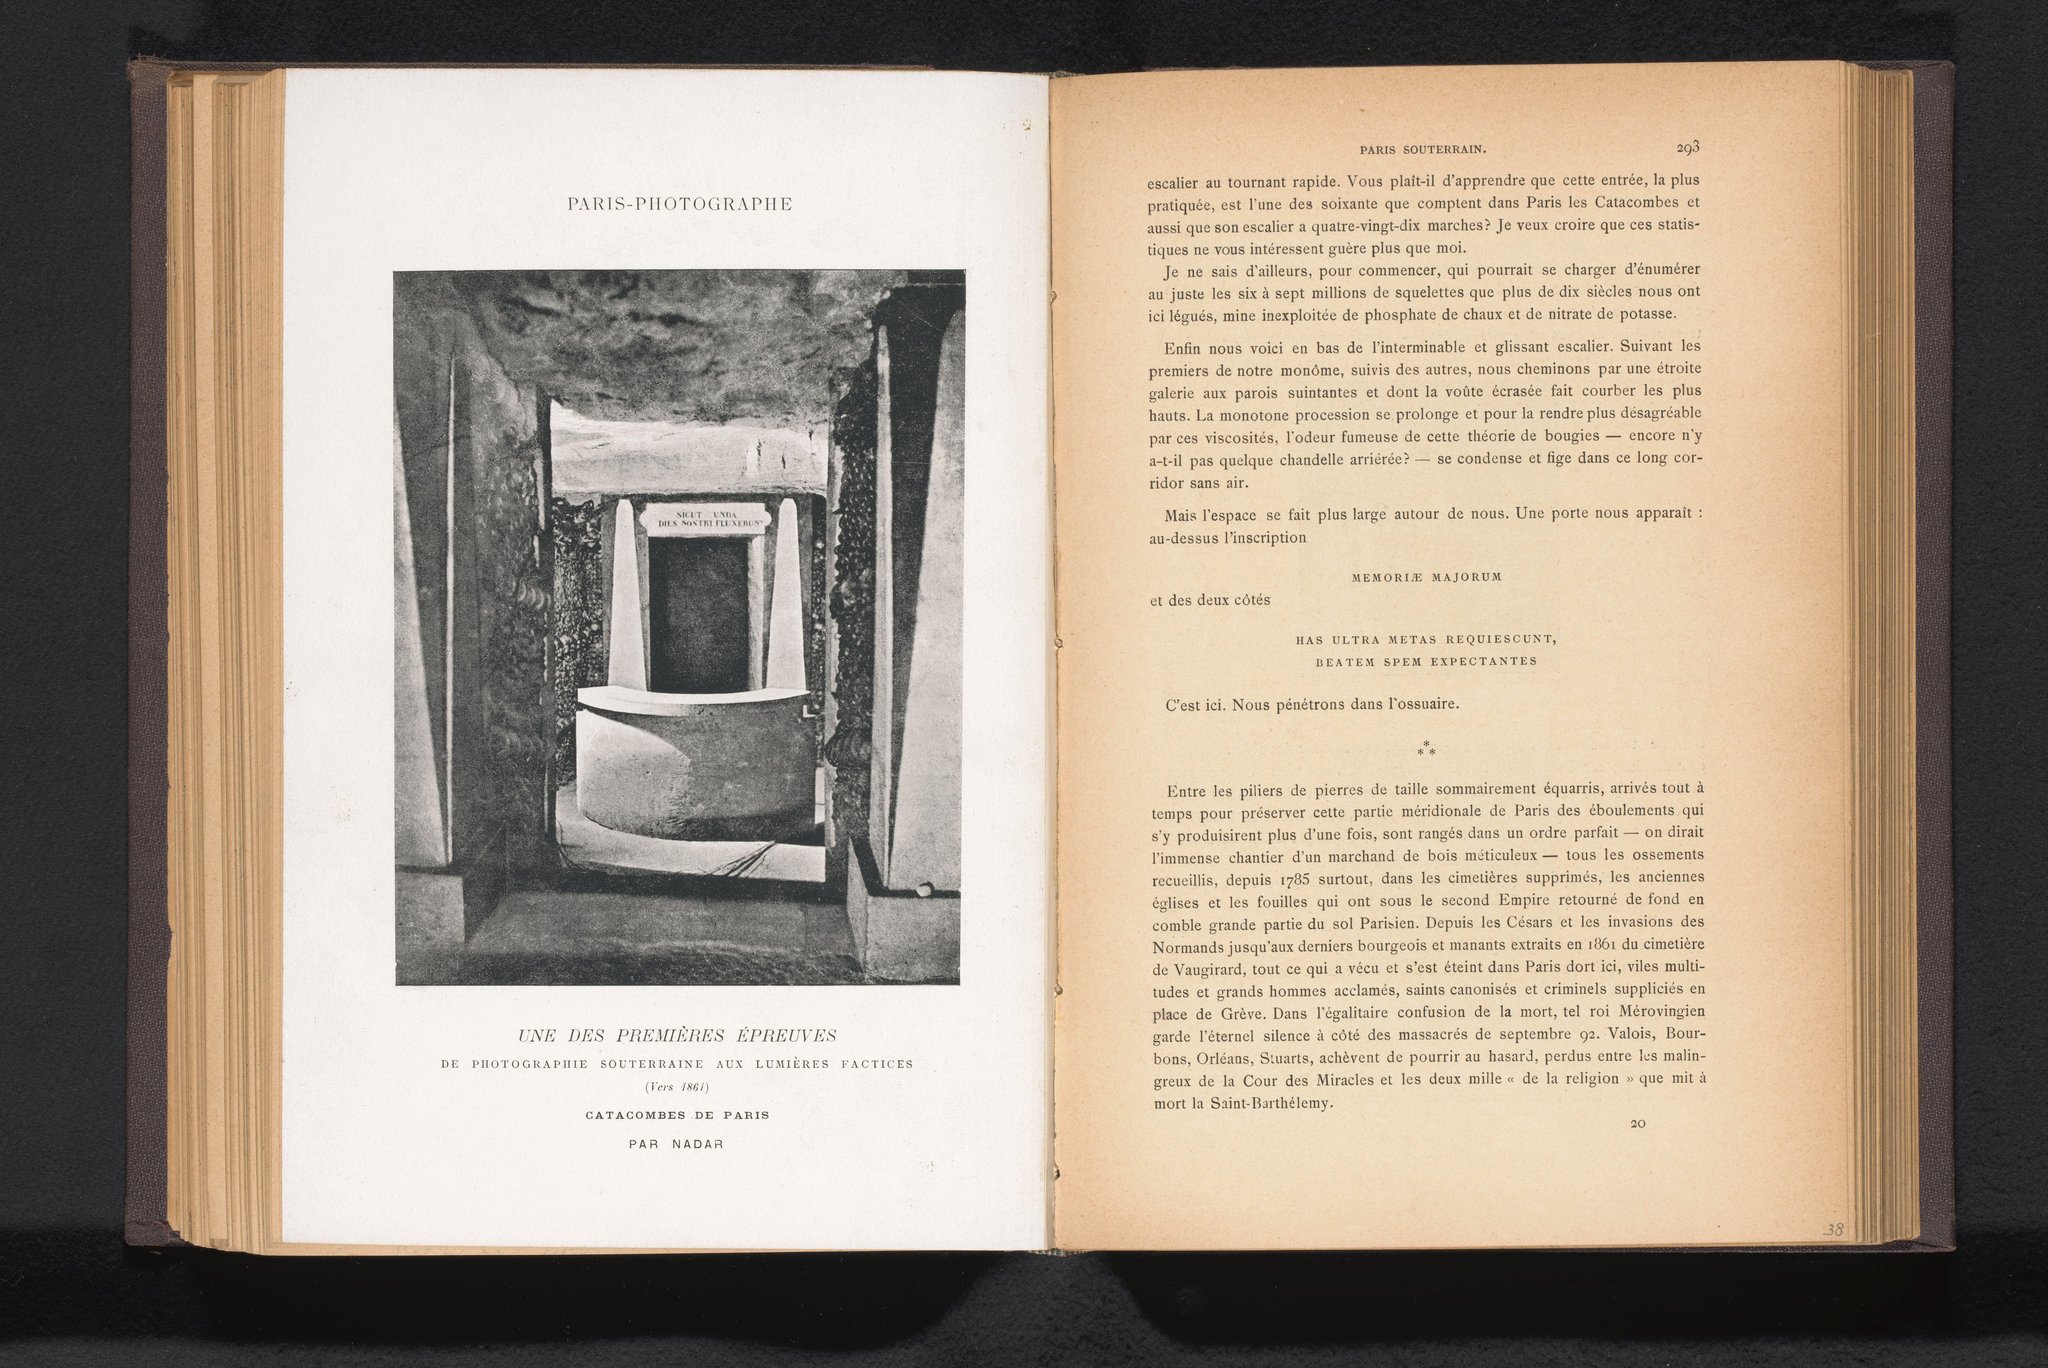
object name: page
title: Interieur van de catacomben van Parijs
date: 1861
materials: paper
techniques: autotype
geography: paris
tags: catacombs